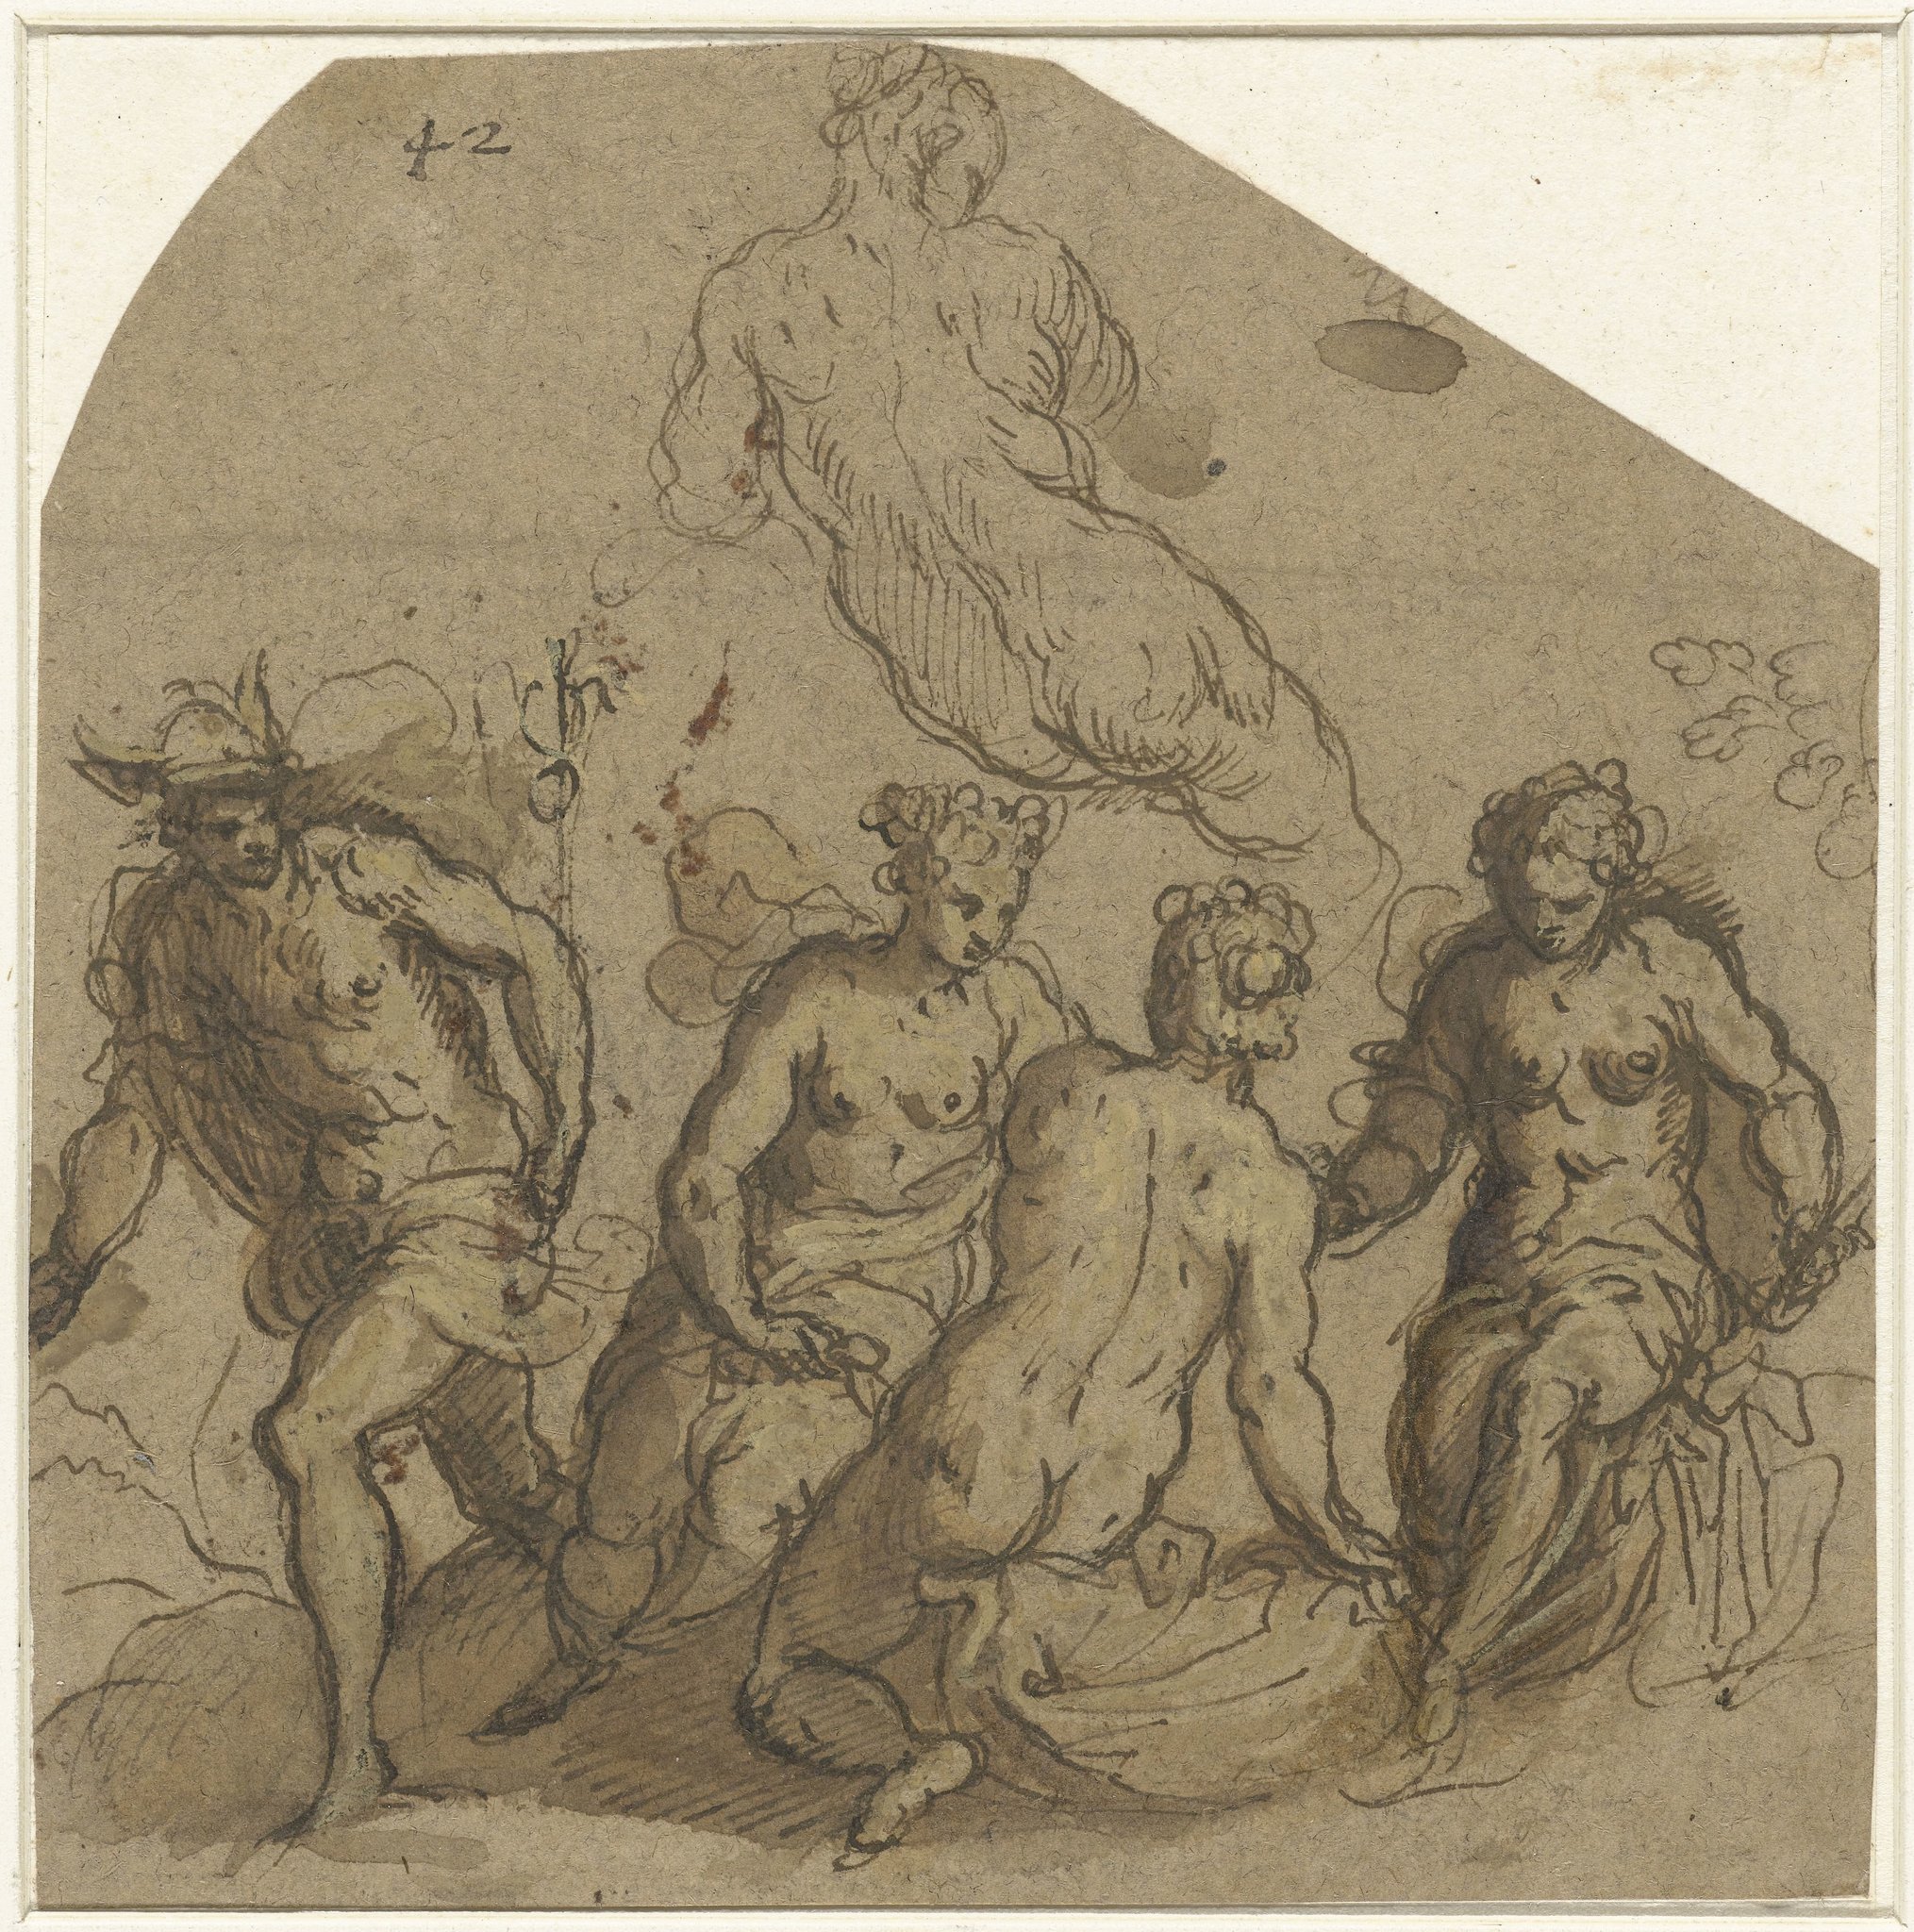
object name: drawing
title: Mercurius verlaat de drie Gratiën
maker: jacopo palma (il giovane)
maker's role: draughtsman, painter, print maker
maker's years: 1544-1628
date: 1575-1585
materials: ink, paper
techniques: brush, pen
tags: (story of) mercury (hermes)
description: Blad afkomstig uit een schetsboek van Palma, vroeger bijeen in de verzameling Liechtenstein.